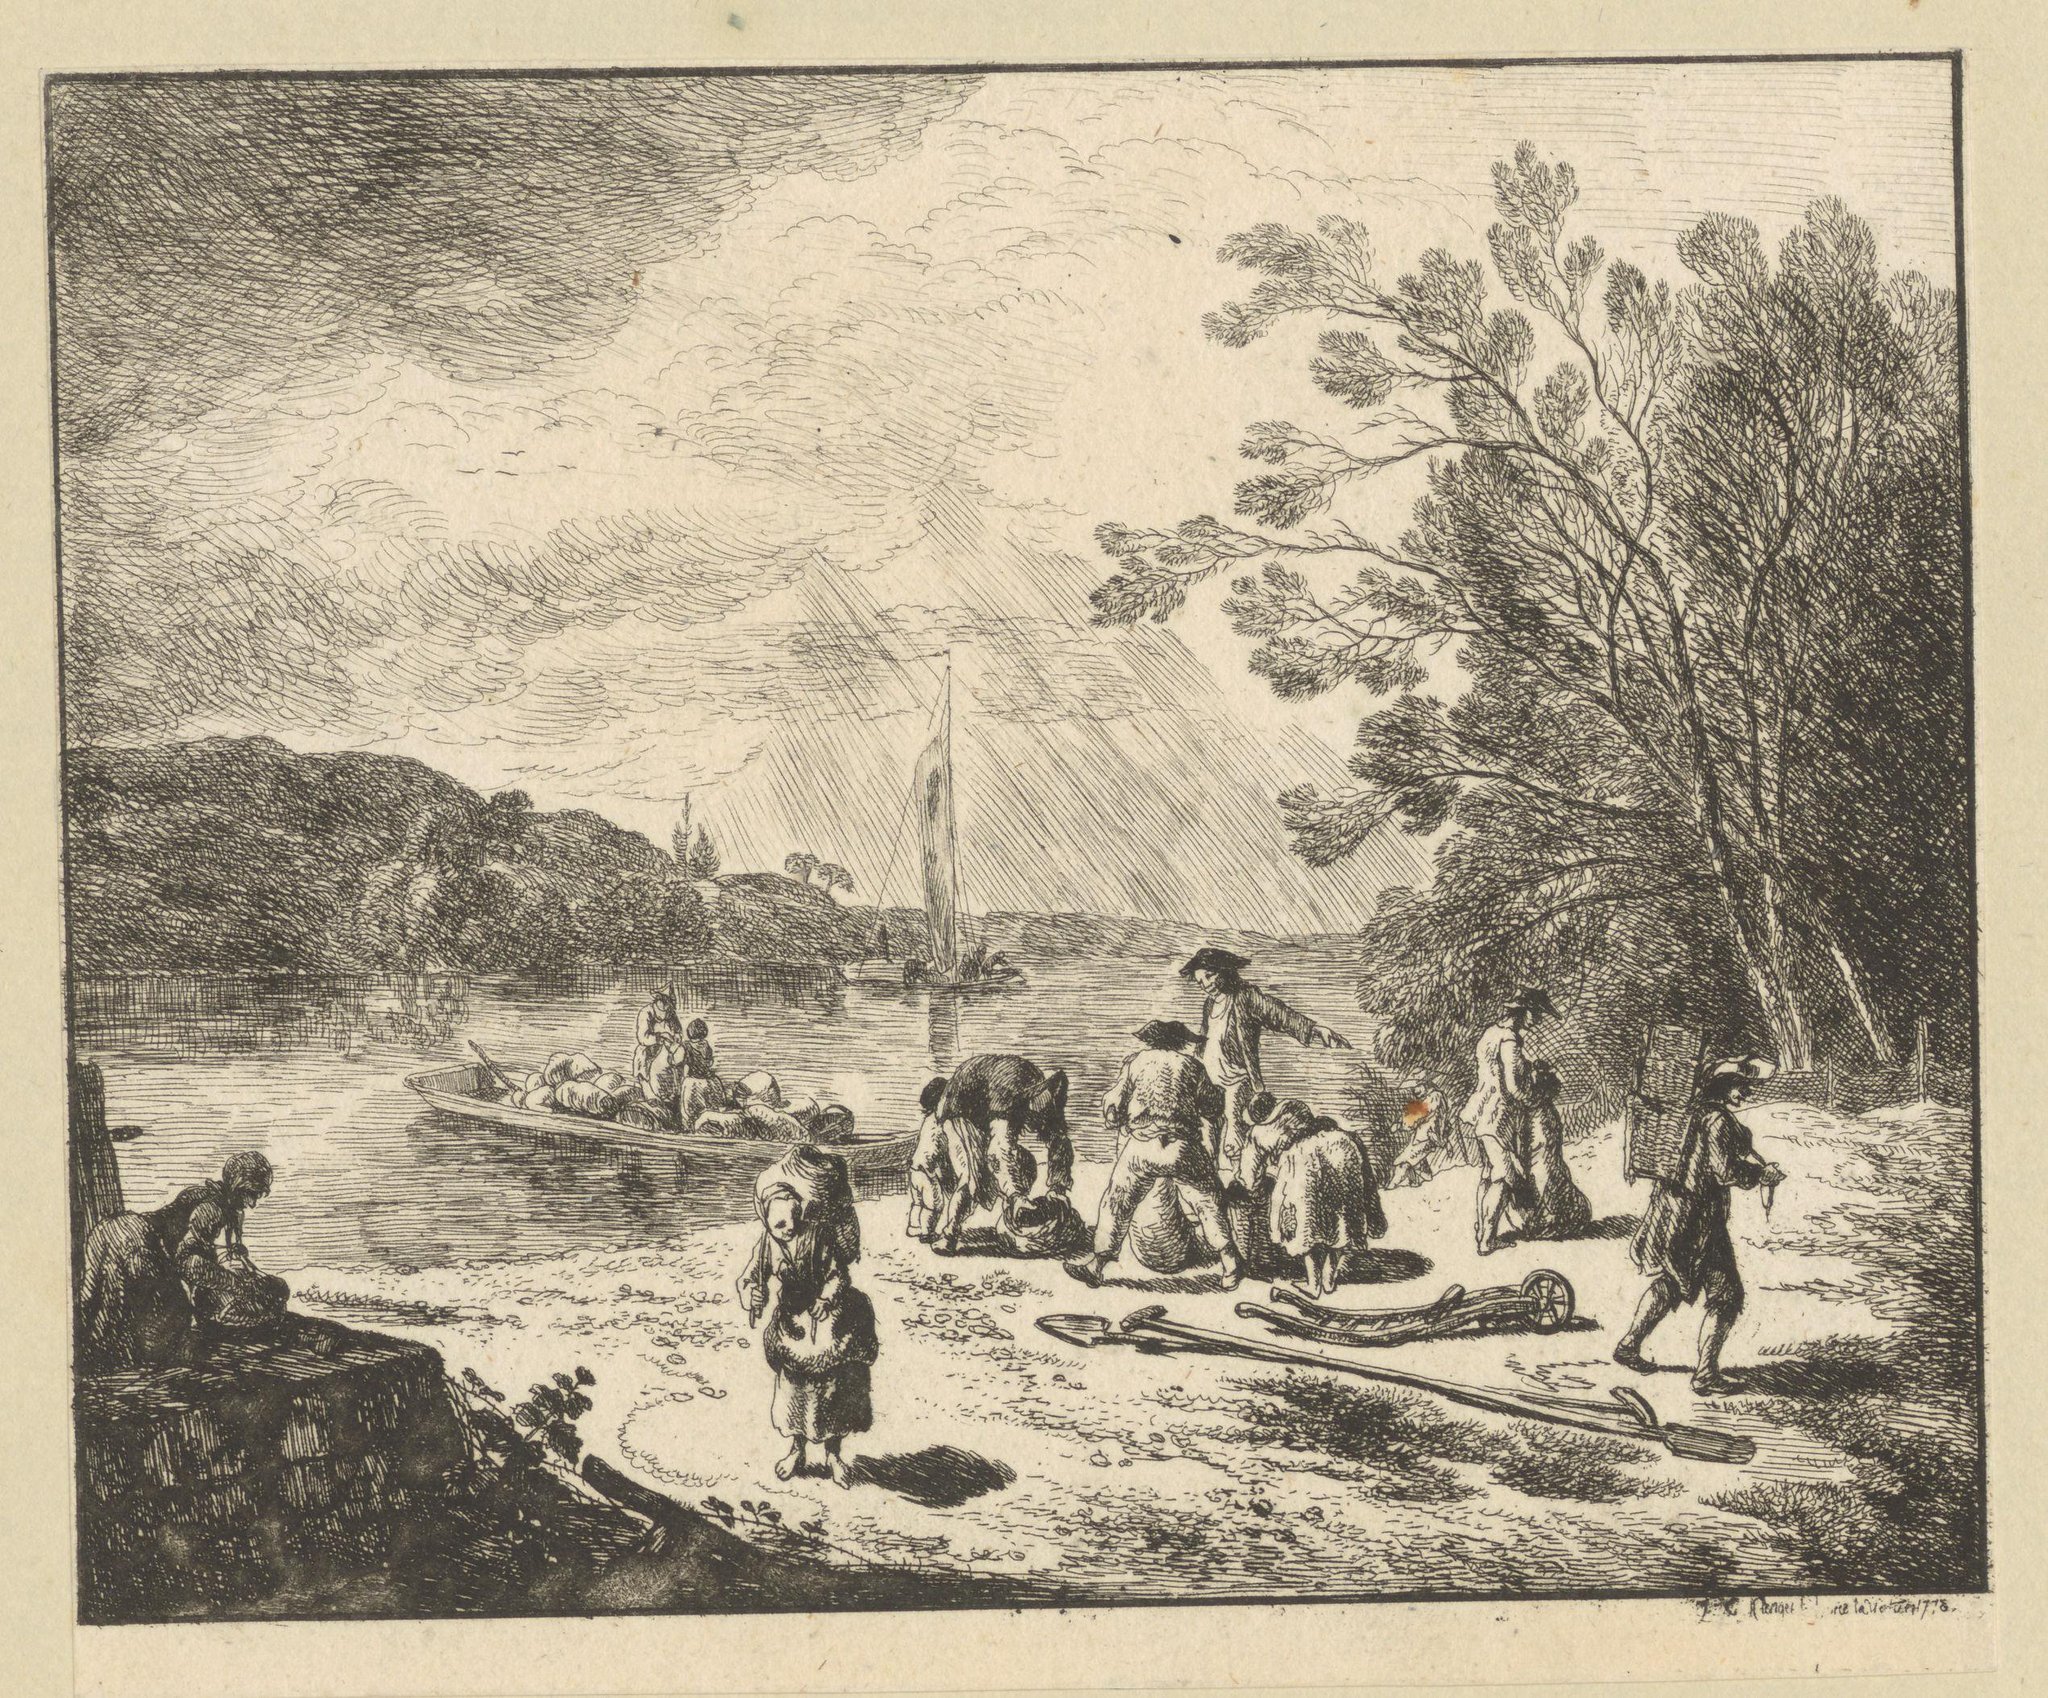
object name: print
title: Landschap met oever waar mannen spullen van een boot laden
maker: johann christian klengel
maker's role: print maker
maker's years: 1751-1824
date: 1773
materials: paper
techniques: etching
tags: rowing-boat, canoe, etc. (+ four persons or more ~ traffic and transport), laundering, ships, boats on land, beached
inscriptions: collector's mark: Lugt 240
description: Links onderin een vrouw die kleding wast. Mannen tillen zakken van de beladen boot om per mand verder te vervoeren. Een andere zeilboot in de binnenvaart.